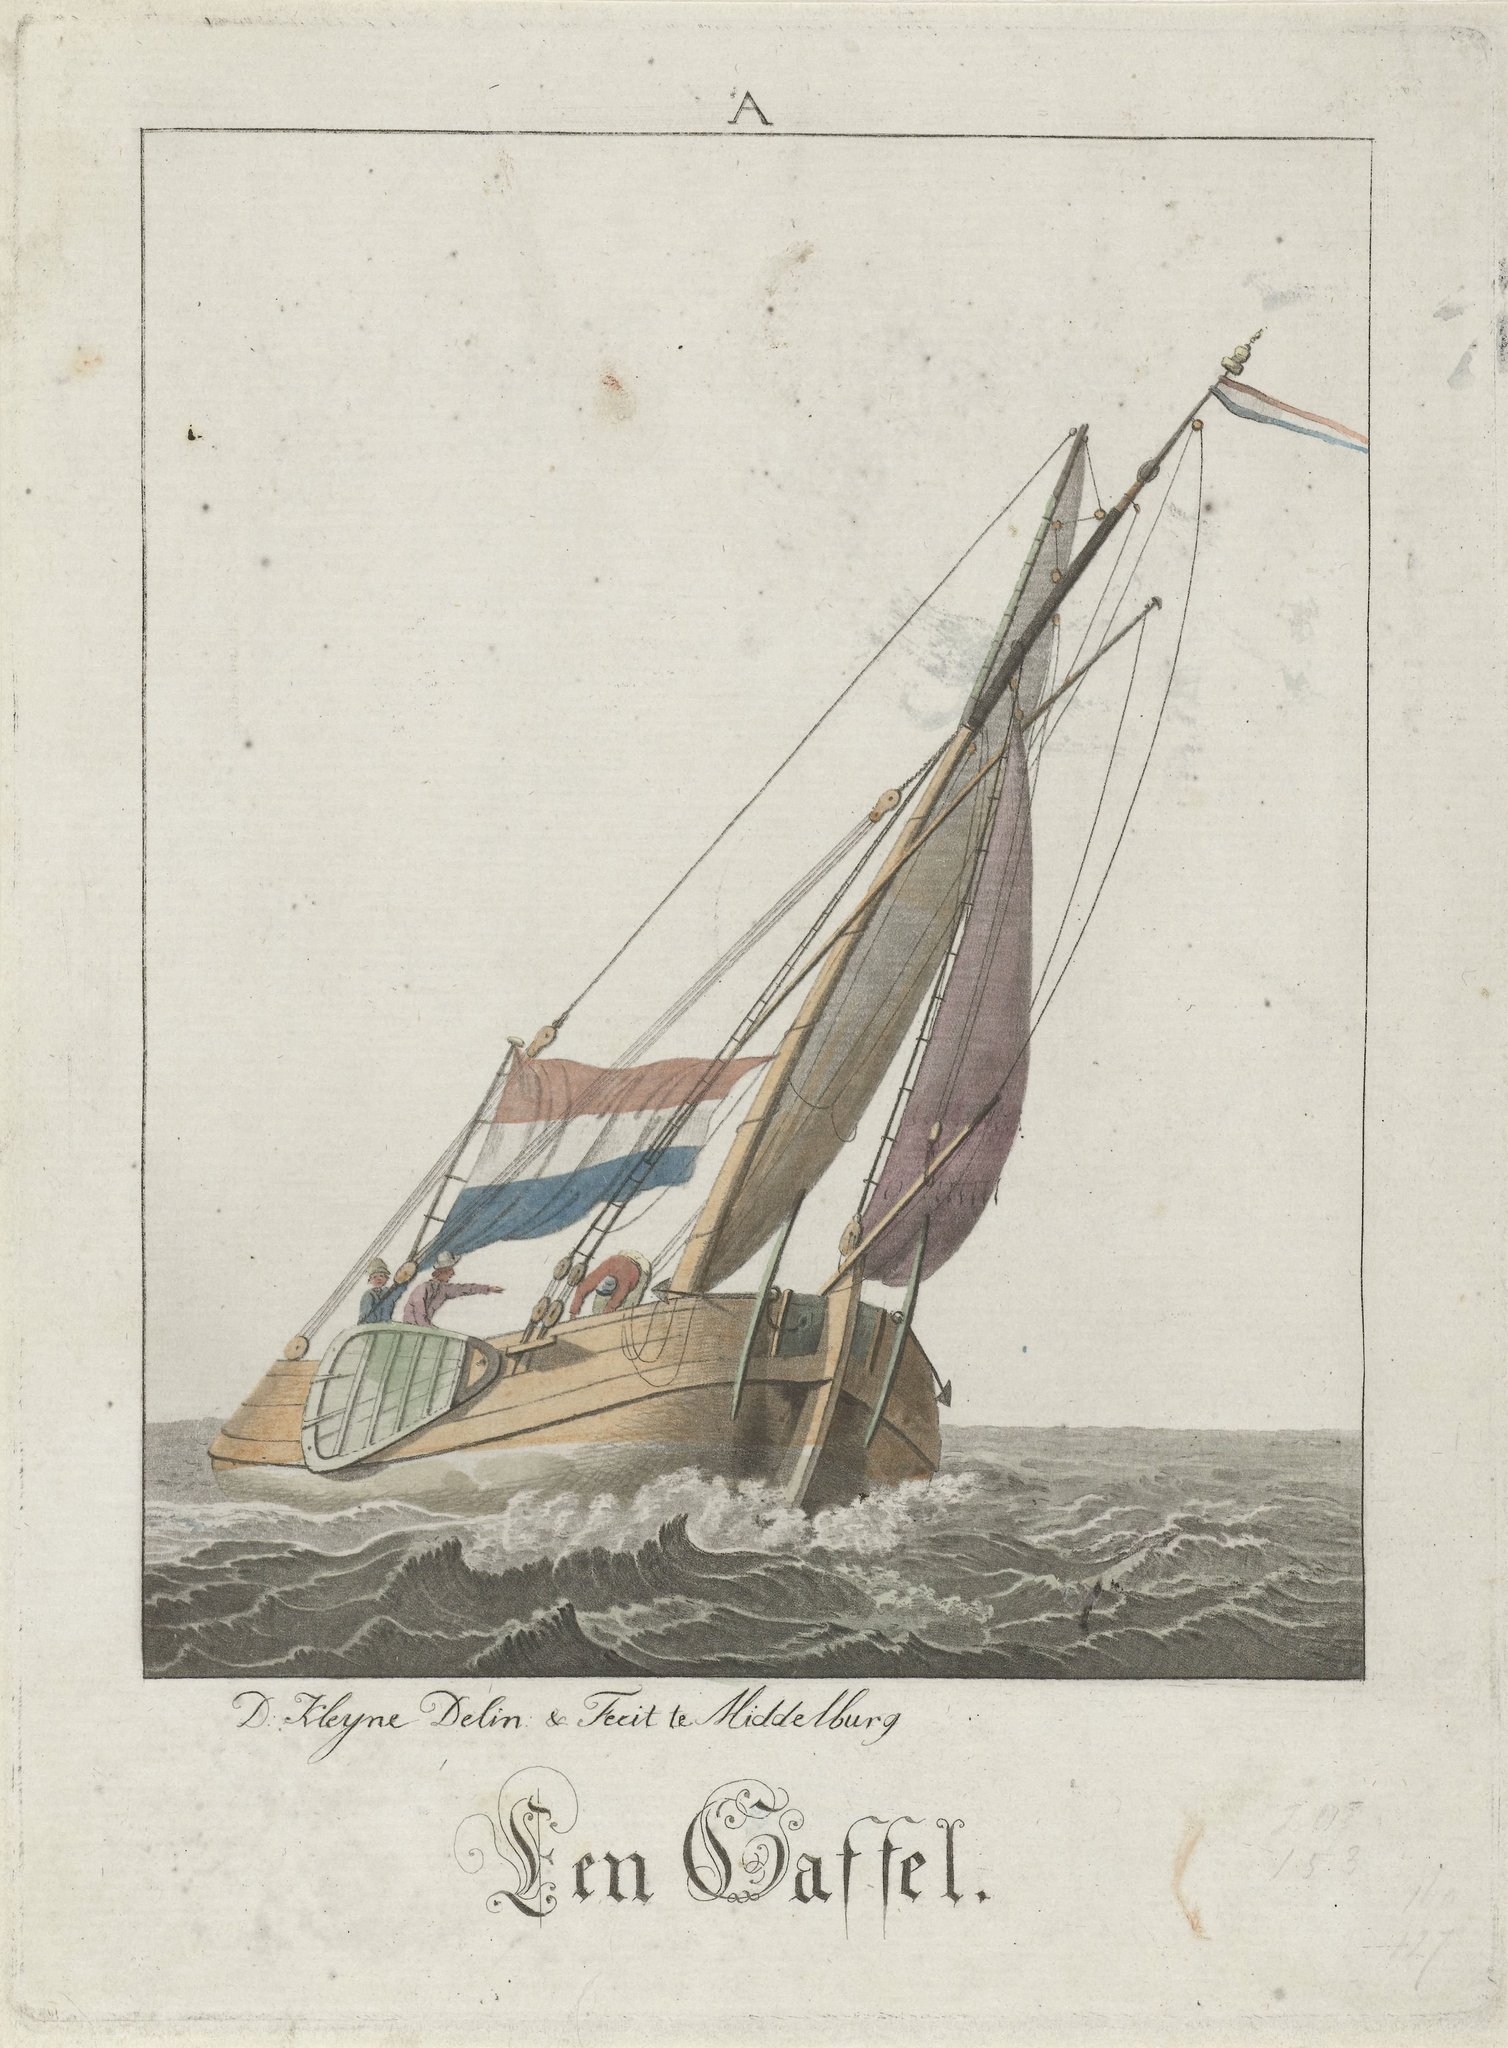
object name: print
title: Gaffel op open water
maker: david kleyne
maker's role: draughtsman, painter, print maker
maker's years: 1754-1805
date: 1763-1805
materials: paper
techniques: aquatint, hand coloring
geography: middelburg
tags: sailing-ship, sailing-boat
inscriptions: collector's mark: Lugt 2228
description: Een gaffel met drie mannen aan boord op open water, varende onder een Nederlandse vlag. De prent maakt deel uit van een serie met zeilschepen.